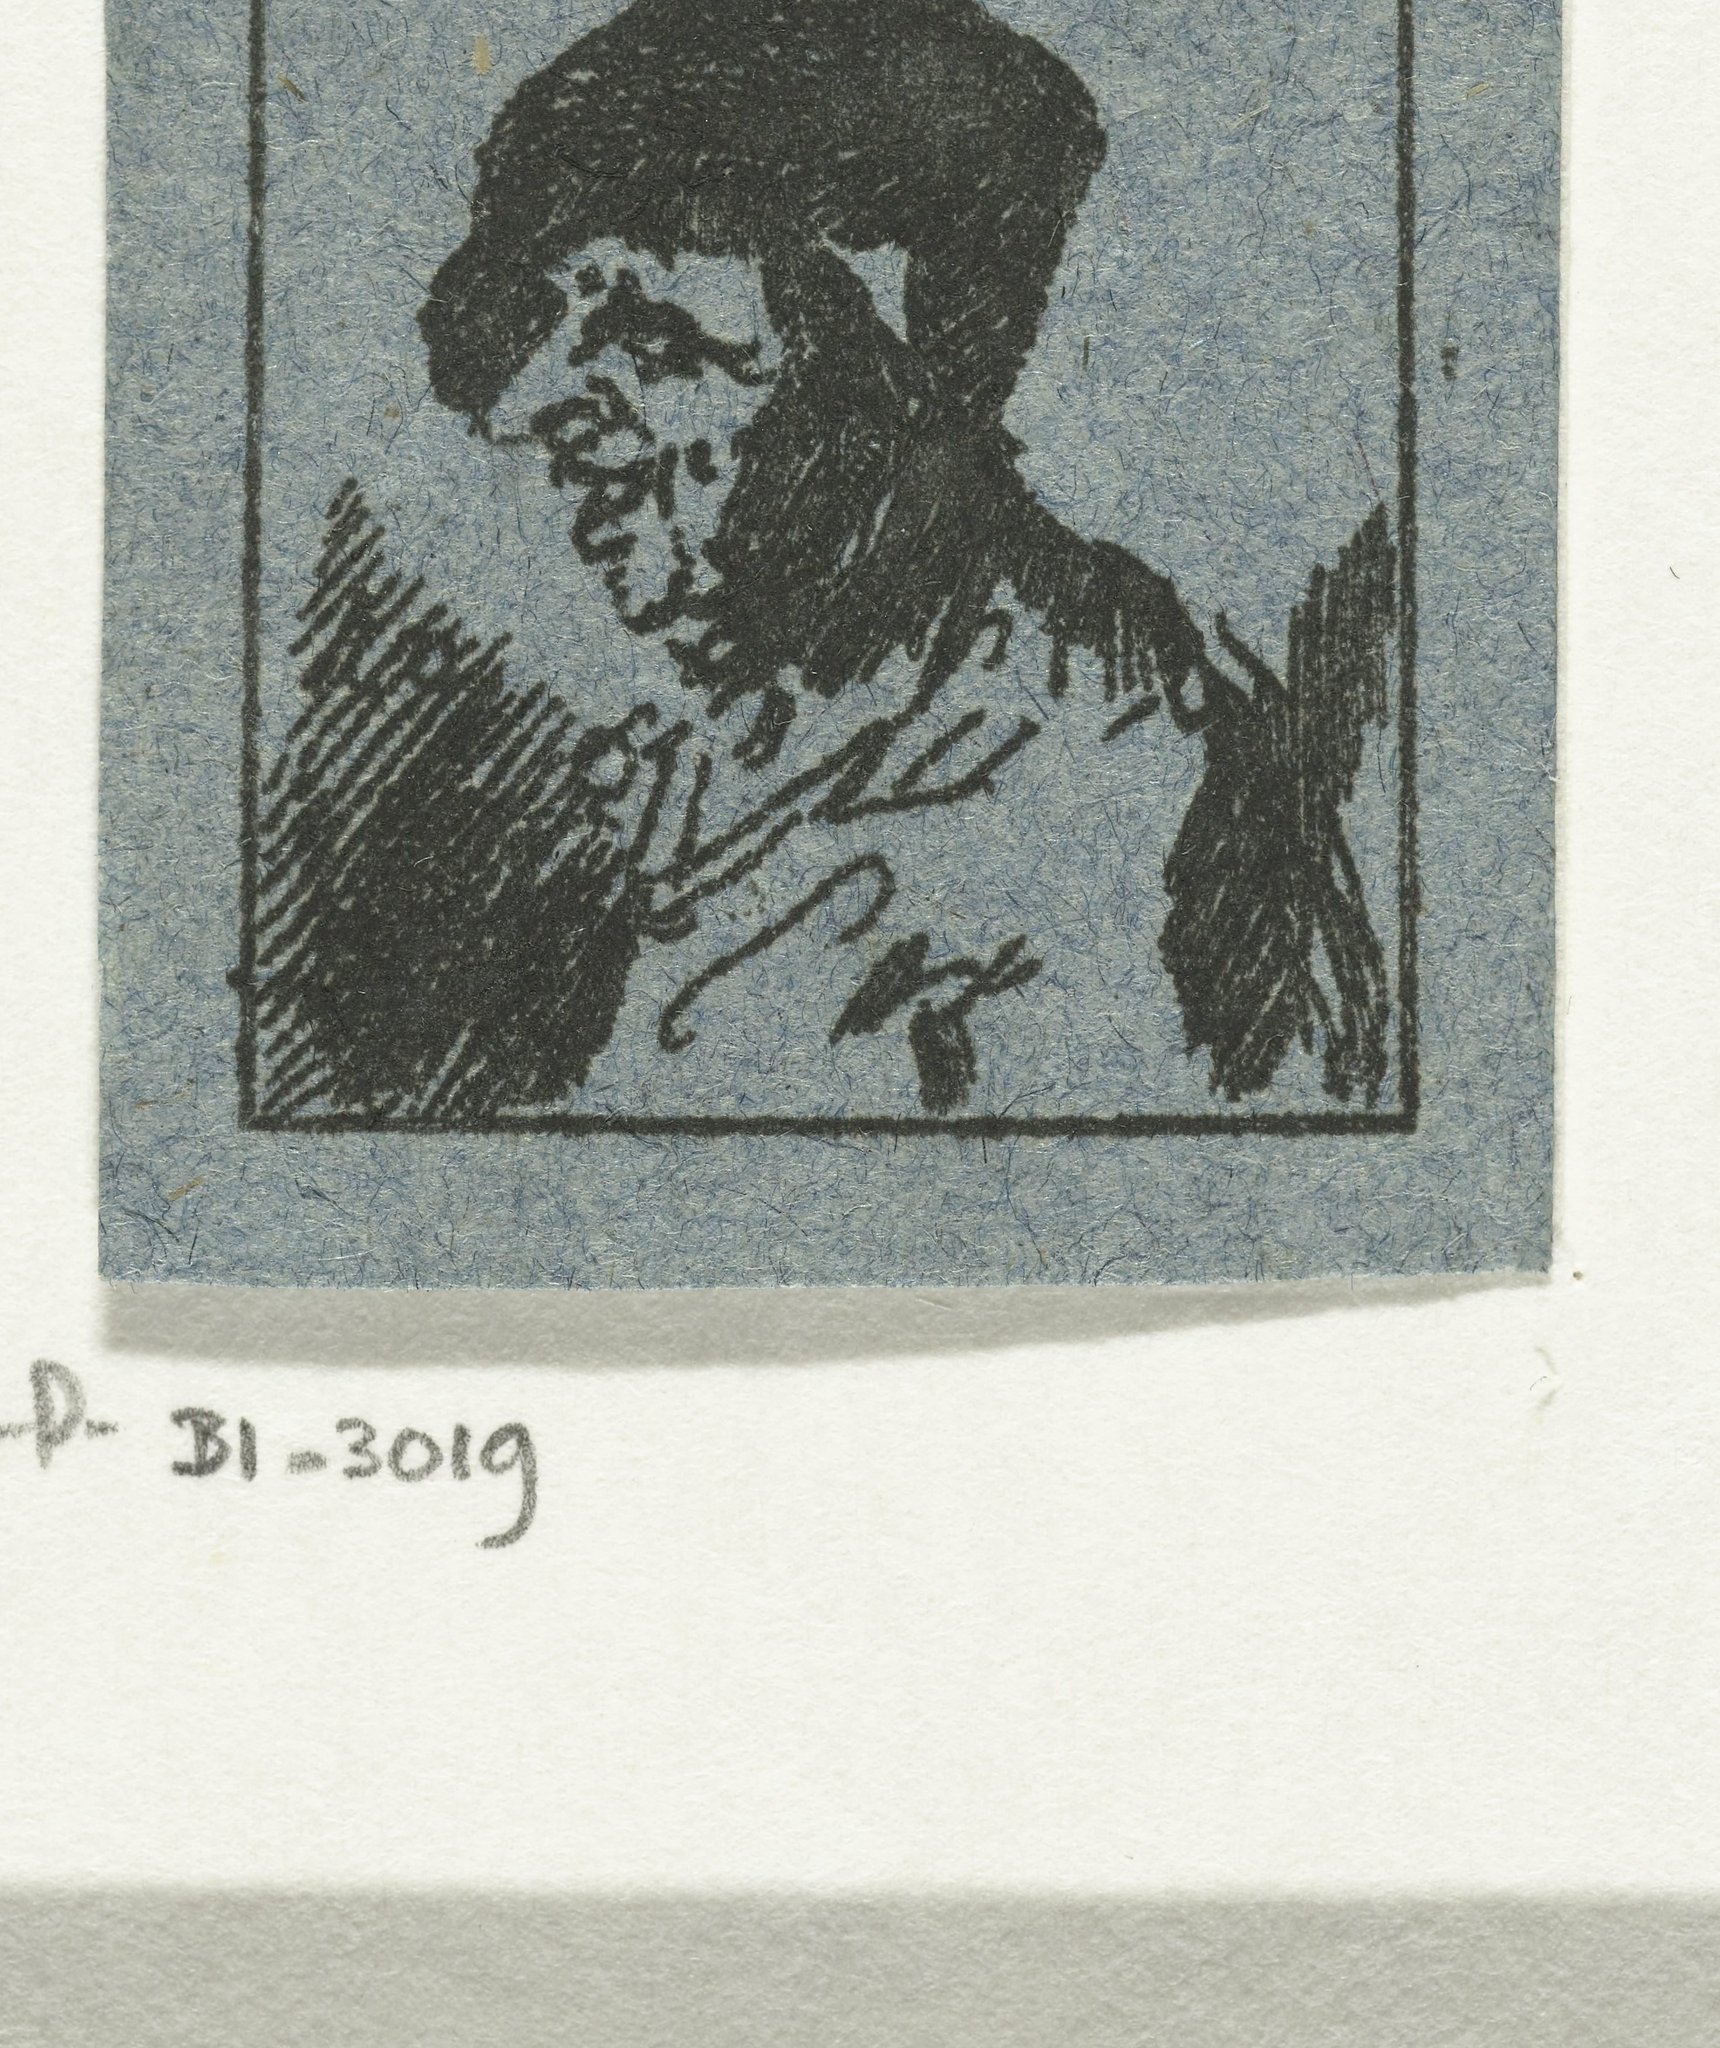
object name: print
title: Buste van lachende boer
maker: anthonie van den bos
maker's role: draughtsman, print maker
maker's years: 1763-1838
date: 1778-1838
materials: paper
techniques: etching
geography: netherlands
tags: laughing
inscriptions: collector's mark: Lugt 2228